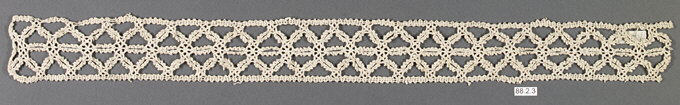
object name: fragment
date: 1567-1600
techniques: lace